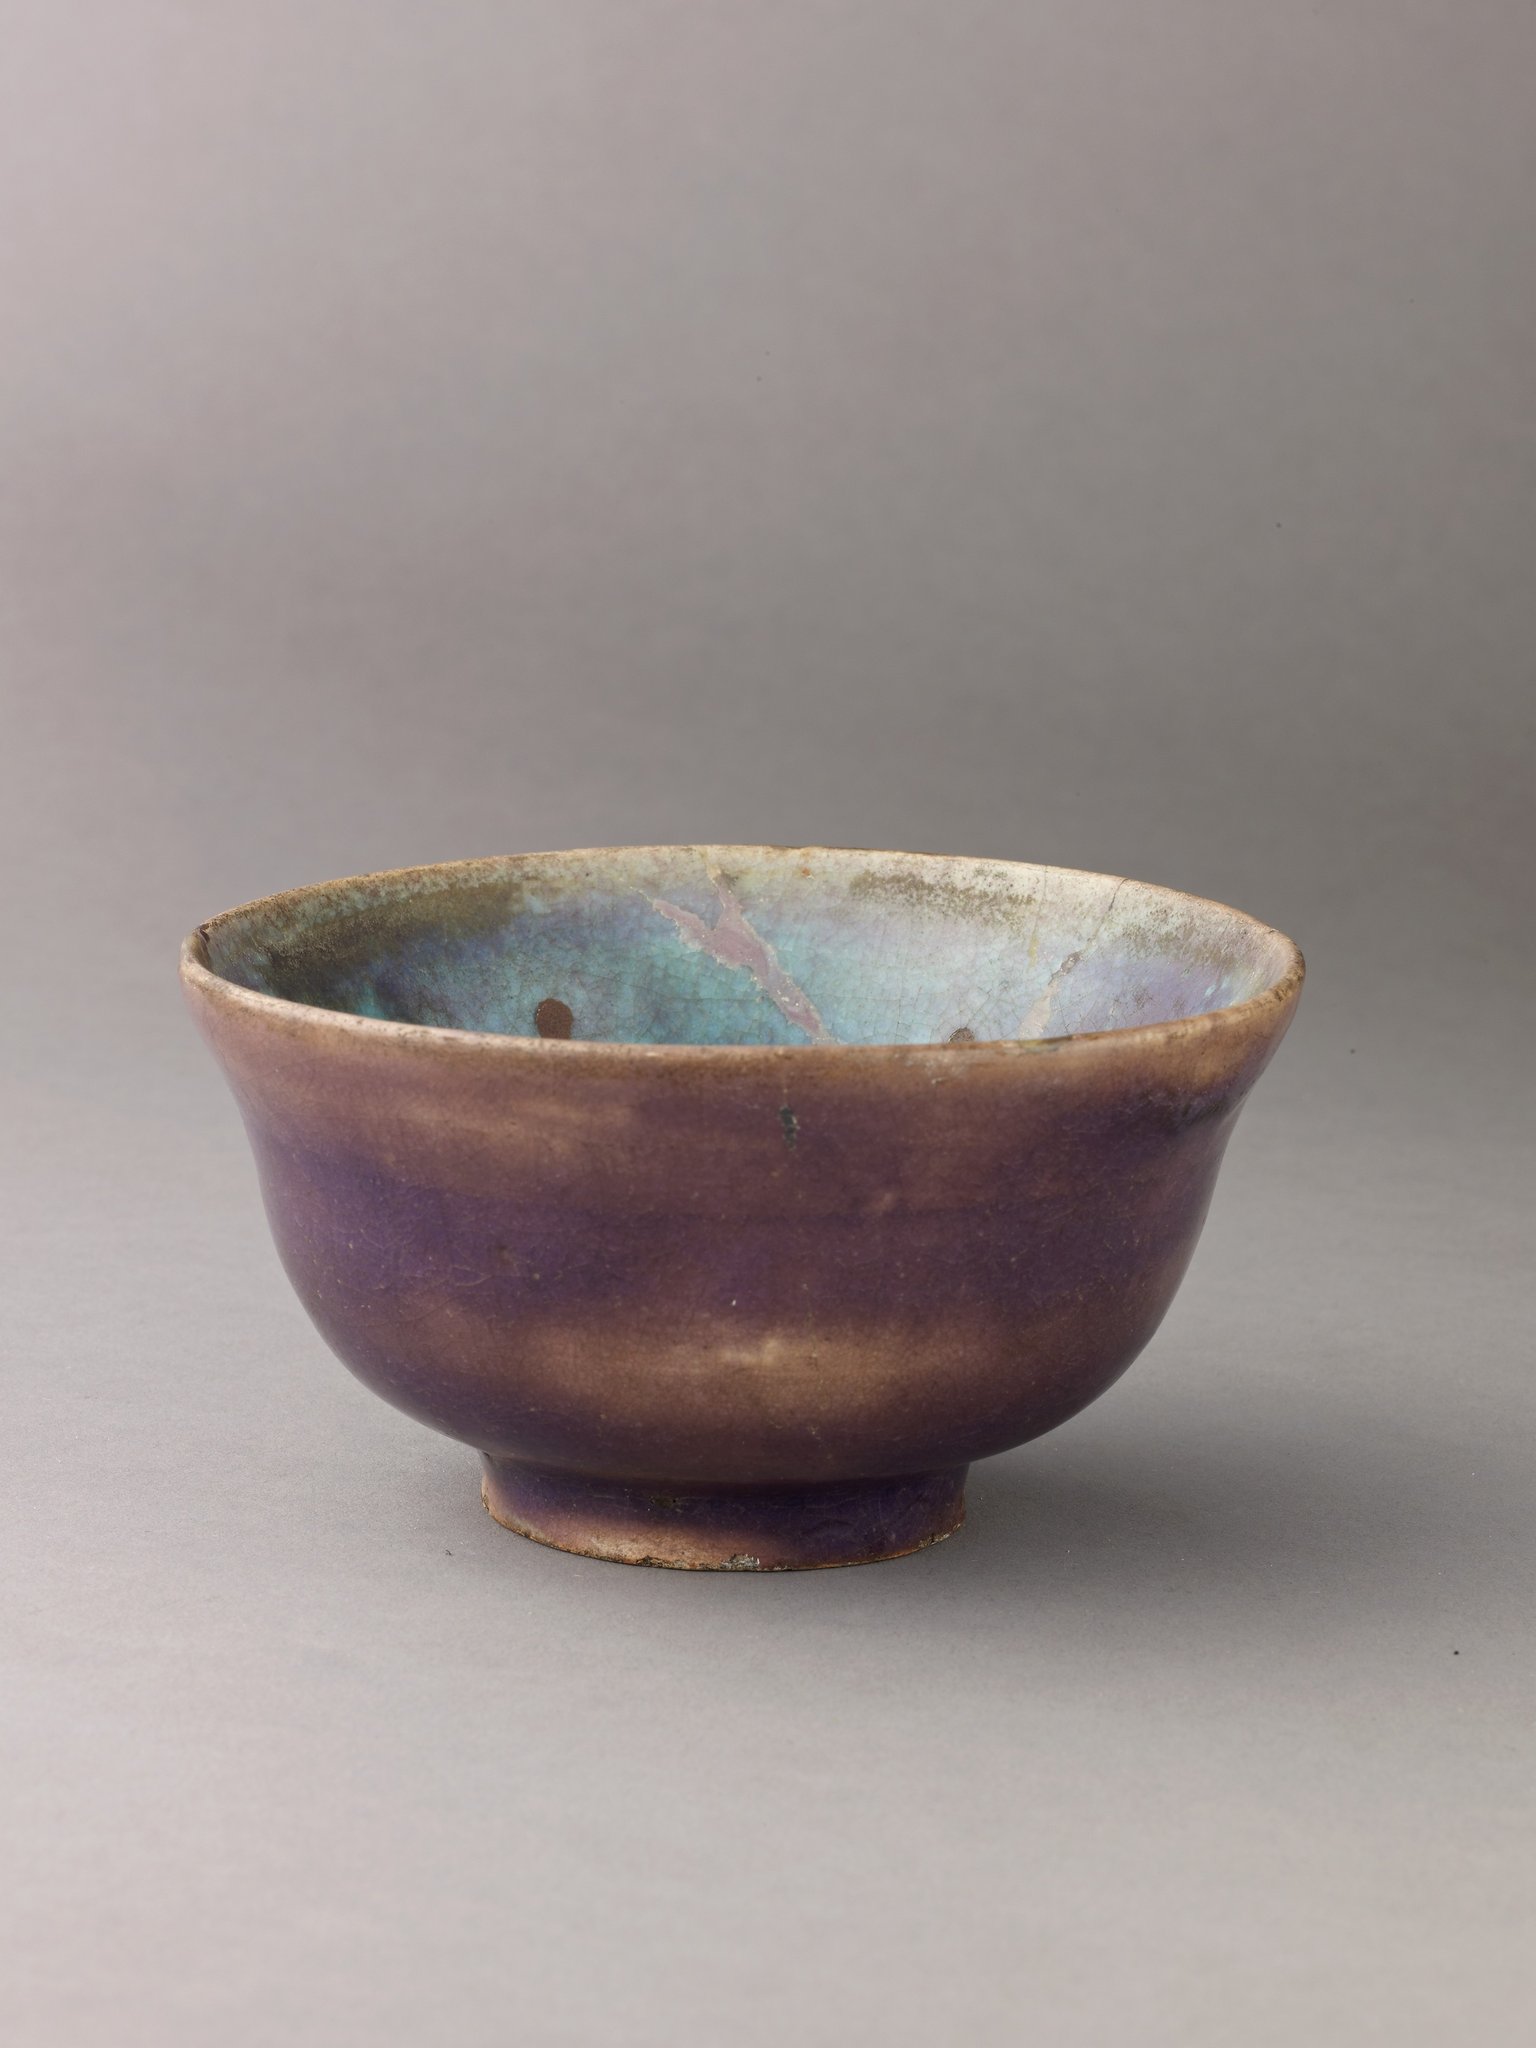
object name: bowl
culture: chinese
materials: glaze, stoneware